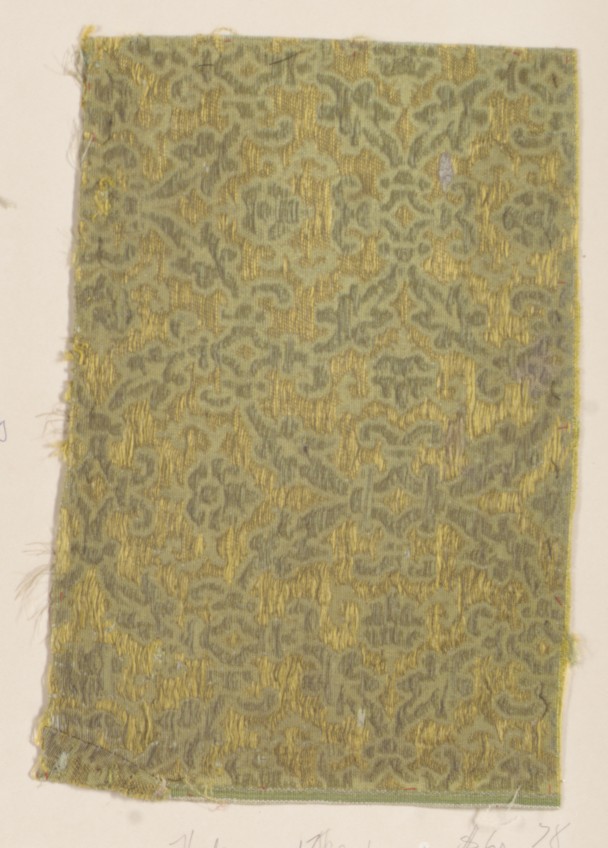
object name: fragment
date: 1601-1700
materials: metal thread, silk